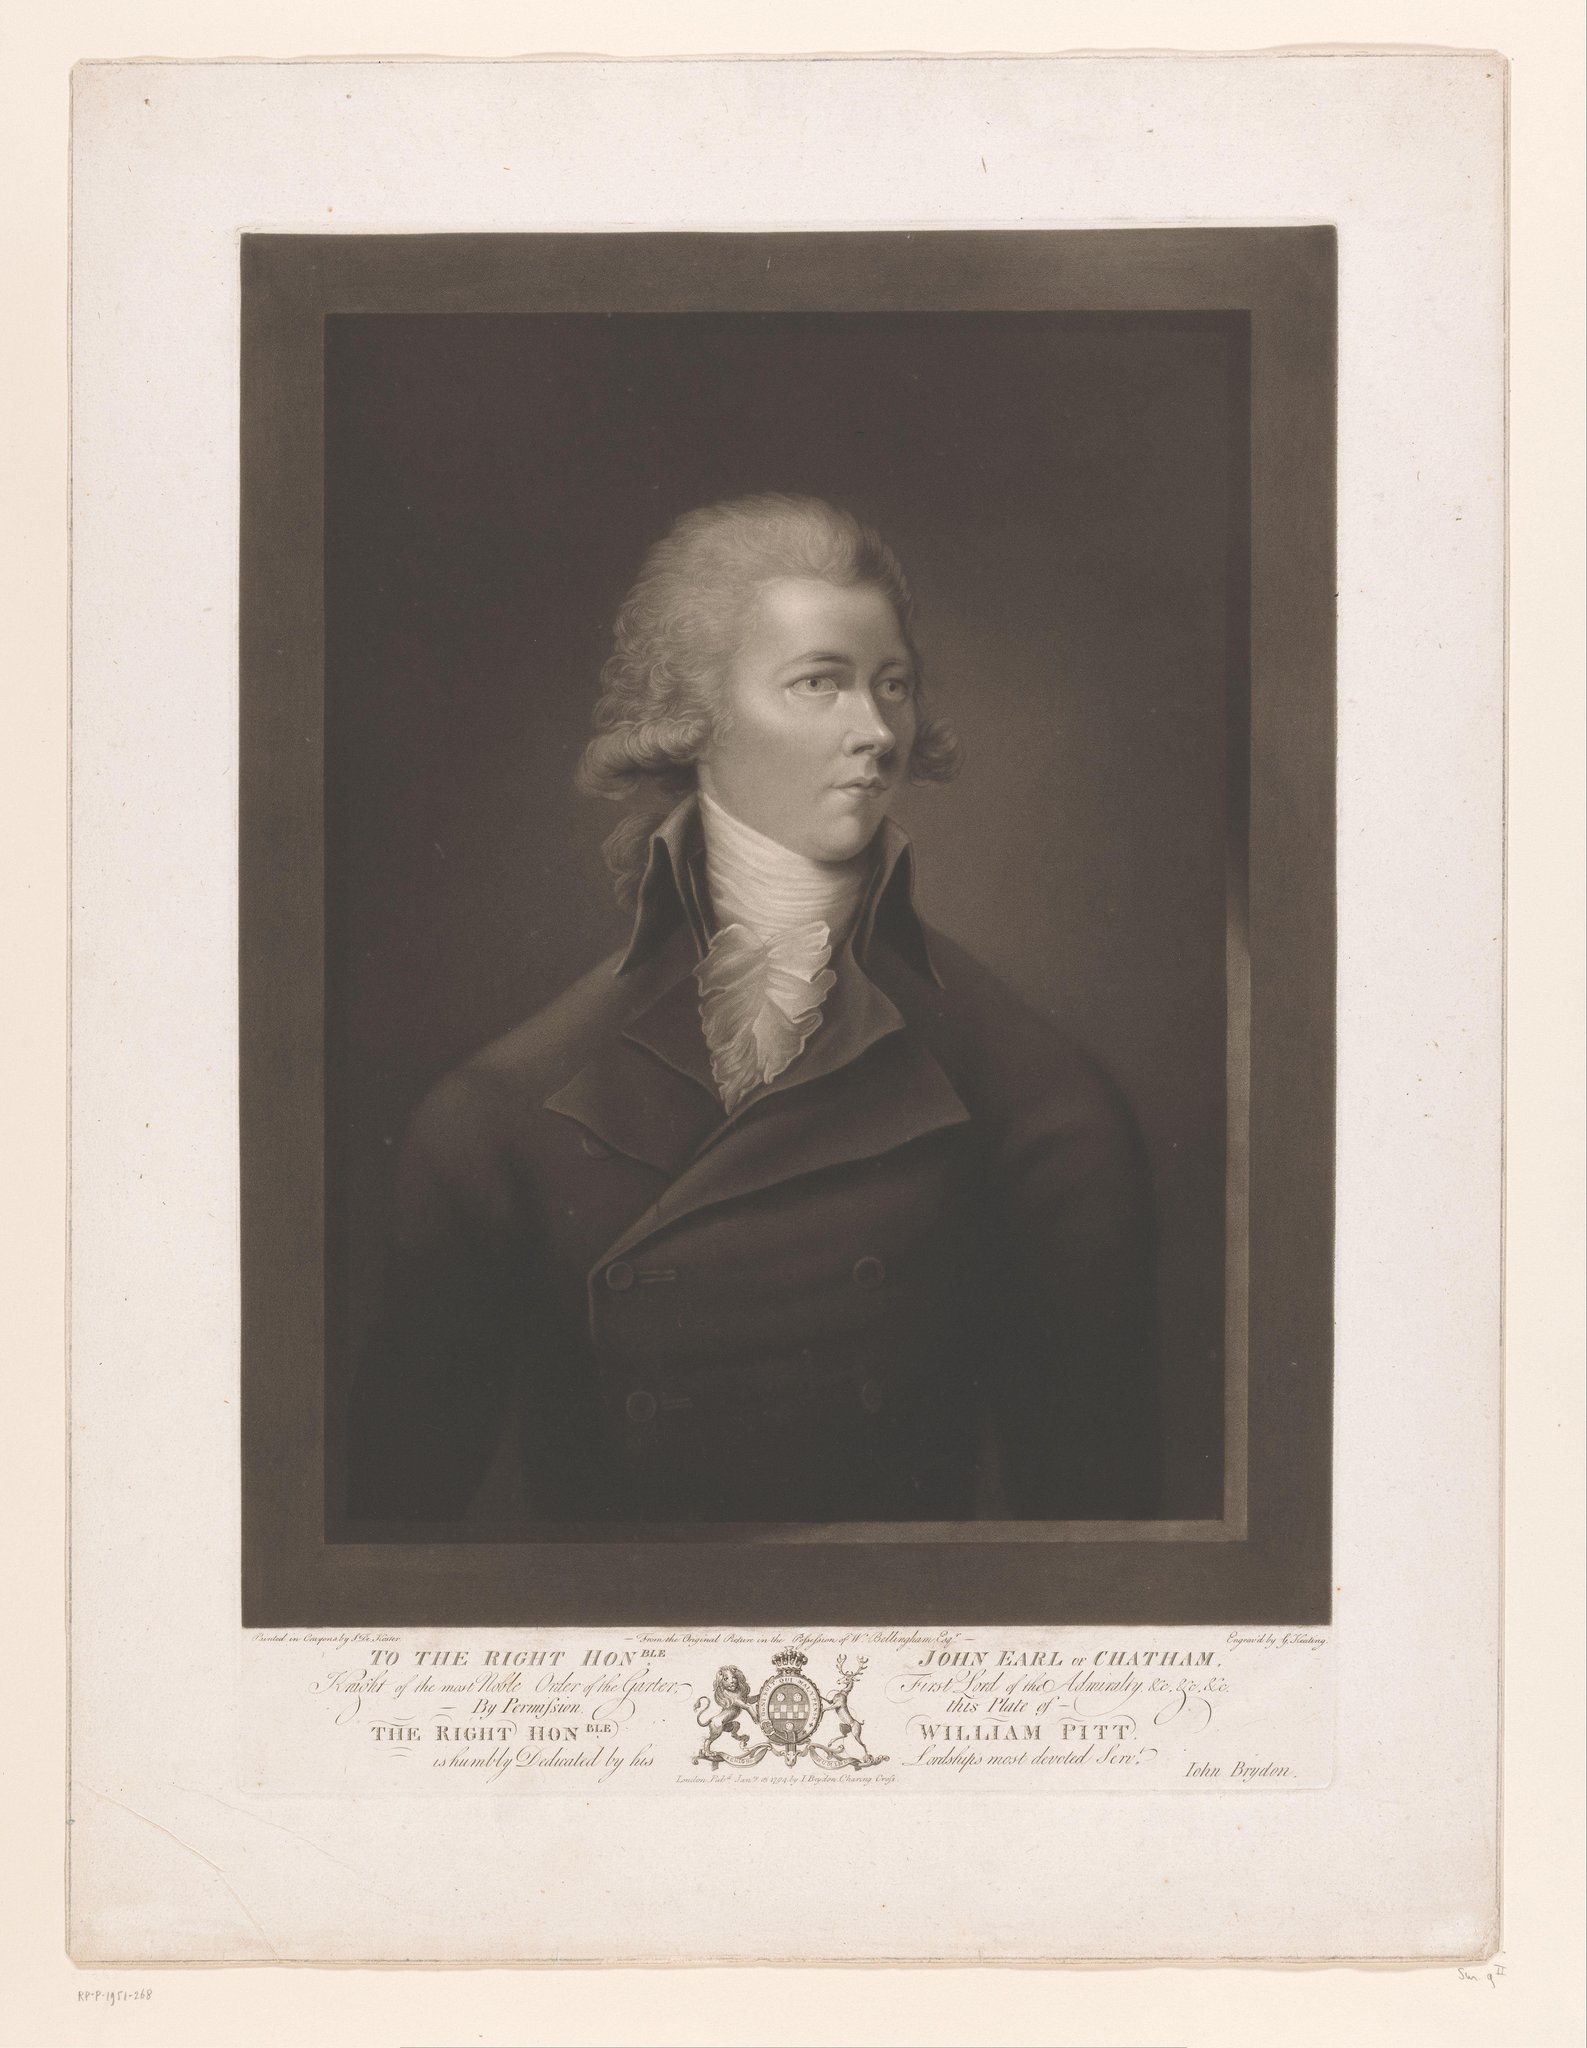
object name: print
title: Portret van William Pitt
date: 1794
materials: paper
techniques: etching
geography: london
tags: london, politician, historical persons, politician, e.g. party leader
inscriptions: collector's mark: Lugt 2228